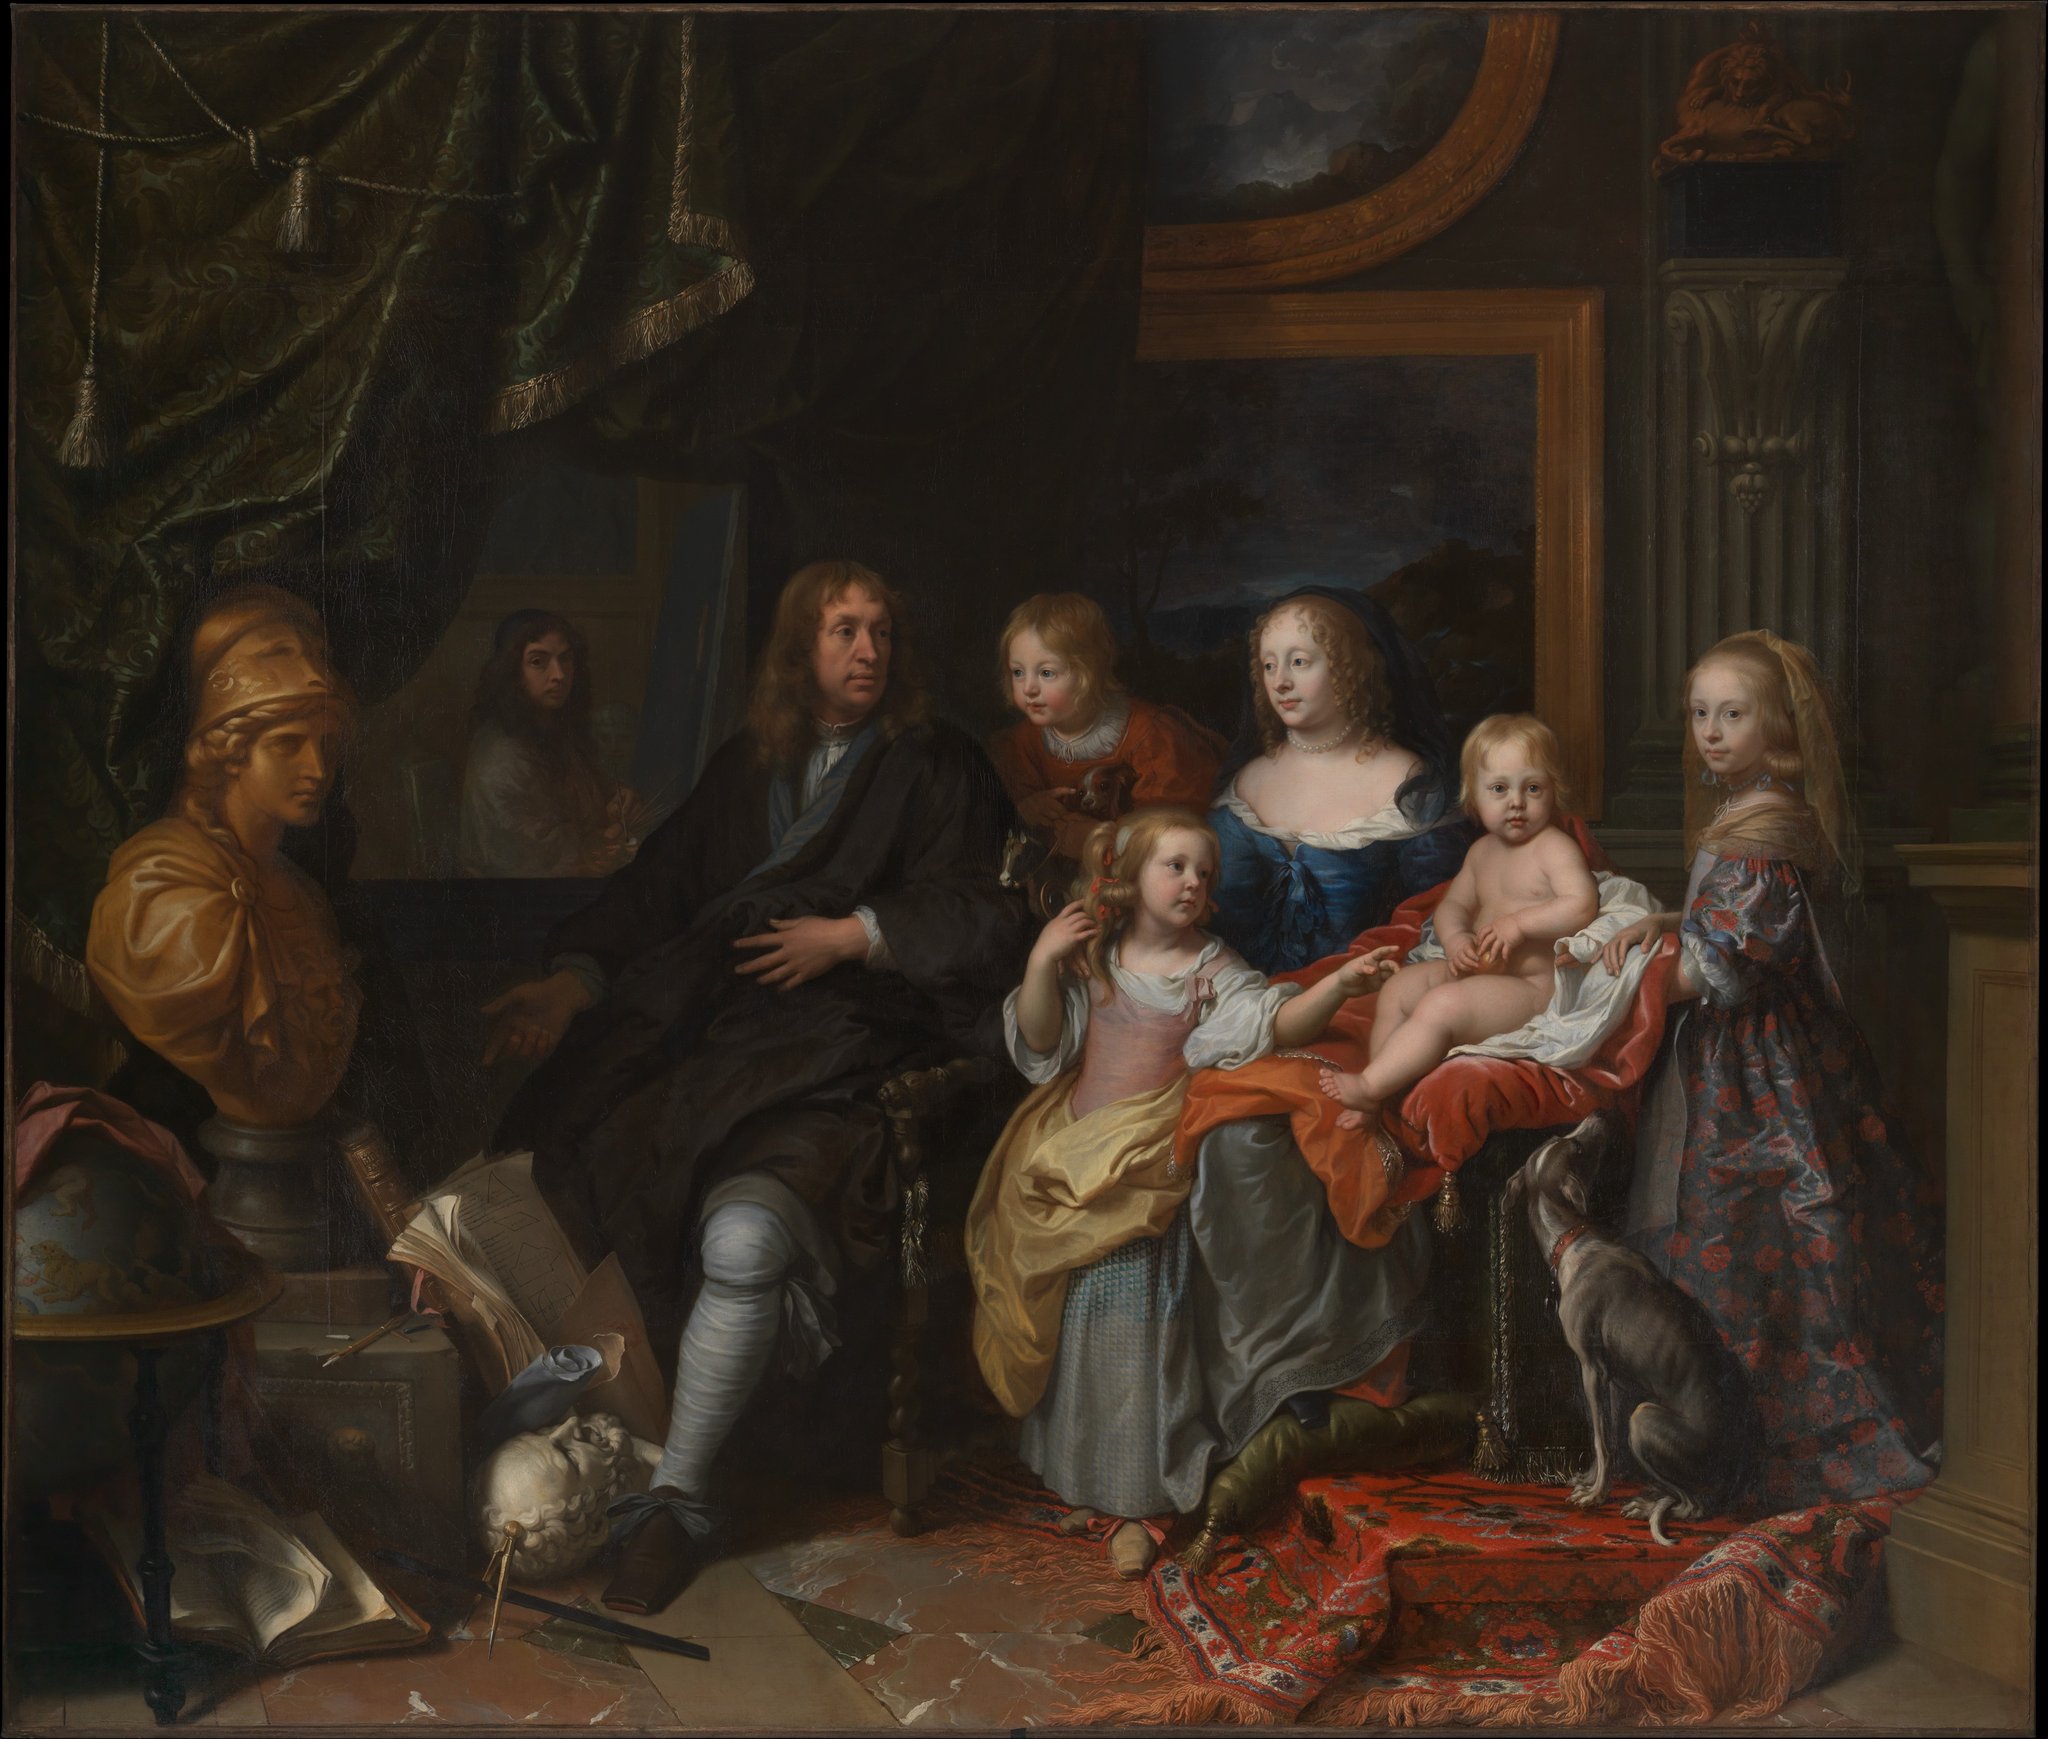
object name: painting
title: The Jabach Family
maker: charles le brun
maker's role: artist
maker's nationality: french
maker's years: 1619-1690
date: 1660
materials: canvas, oil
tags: interiors,boys,girls,infants,men,self-portraits,women,dogs,family